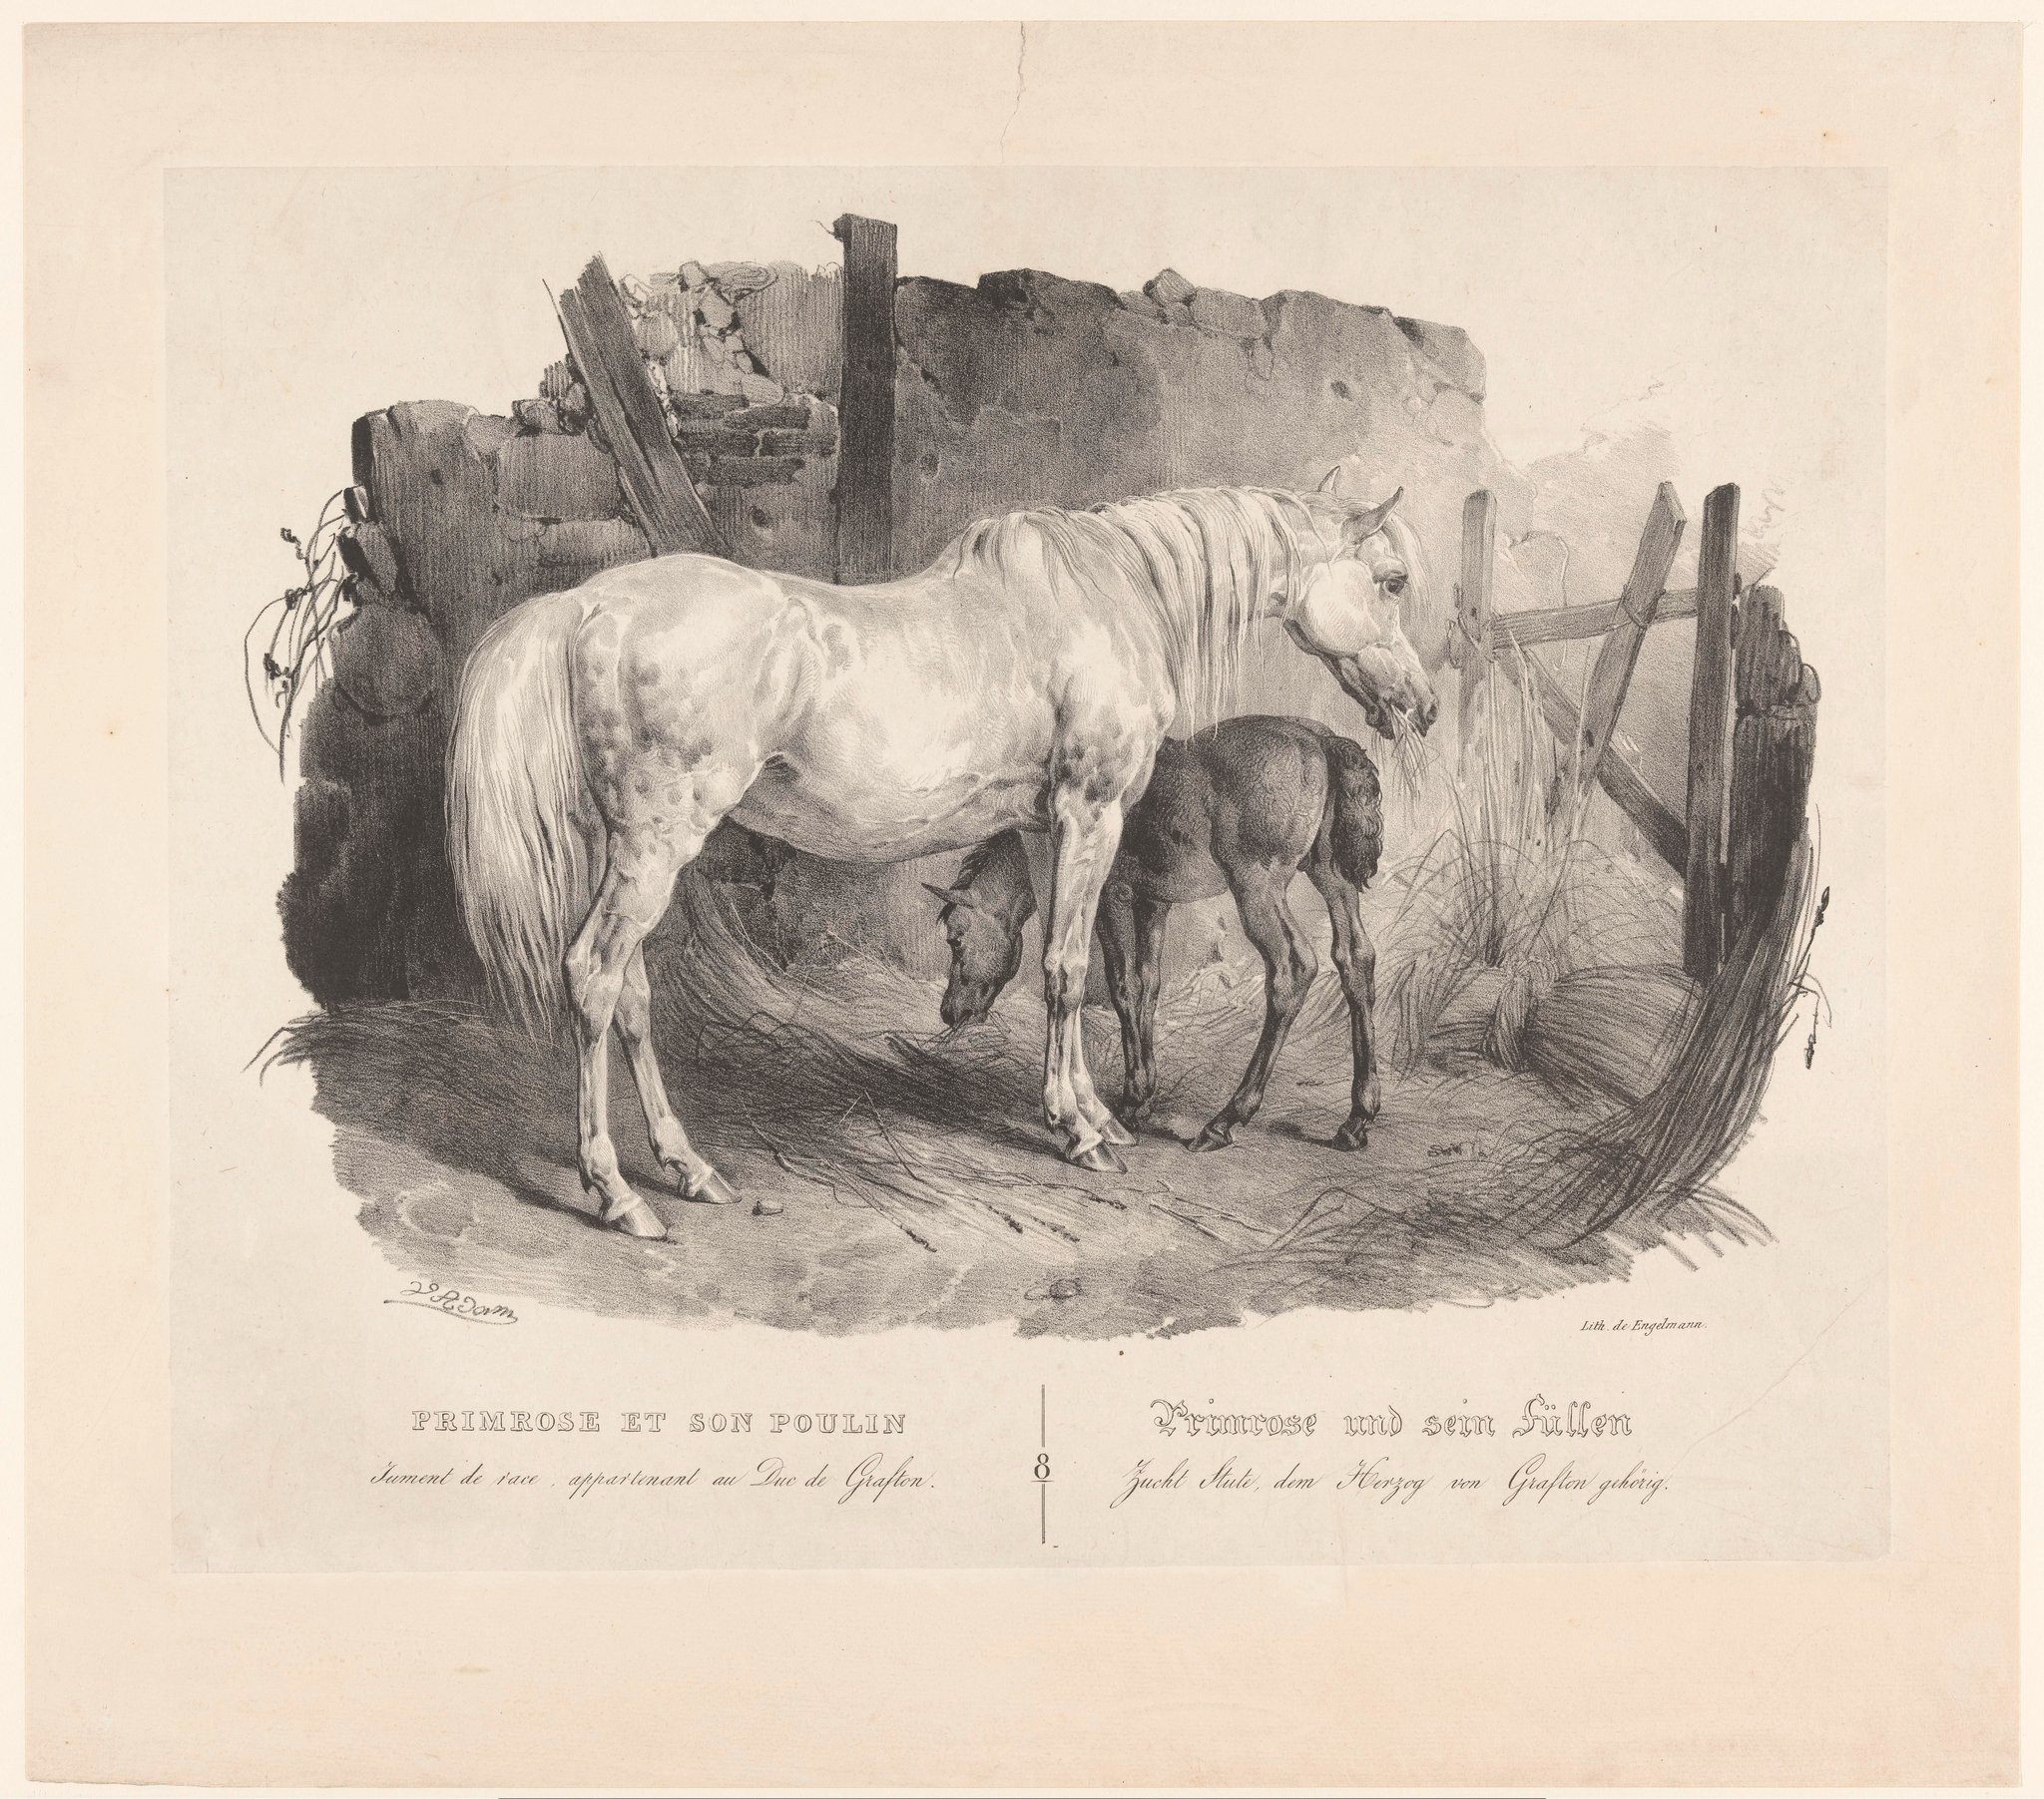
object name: print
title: Primrose et son poulain. Jument de race, appartenant au Duc de Grafton / Primrose und sein Füllen. Zucht Stute, dem Herzog von Grafton gehörig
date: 1825-1827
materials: paper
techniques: lithograph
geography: paris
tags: horse, stall, stable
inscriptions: collector's mark: Lugt 2228